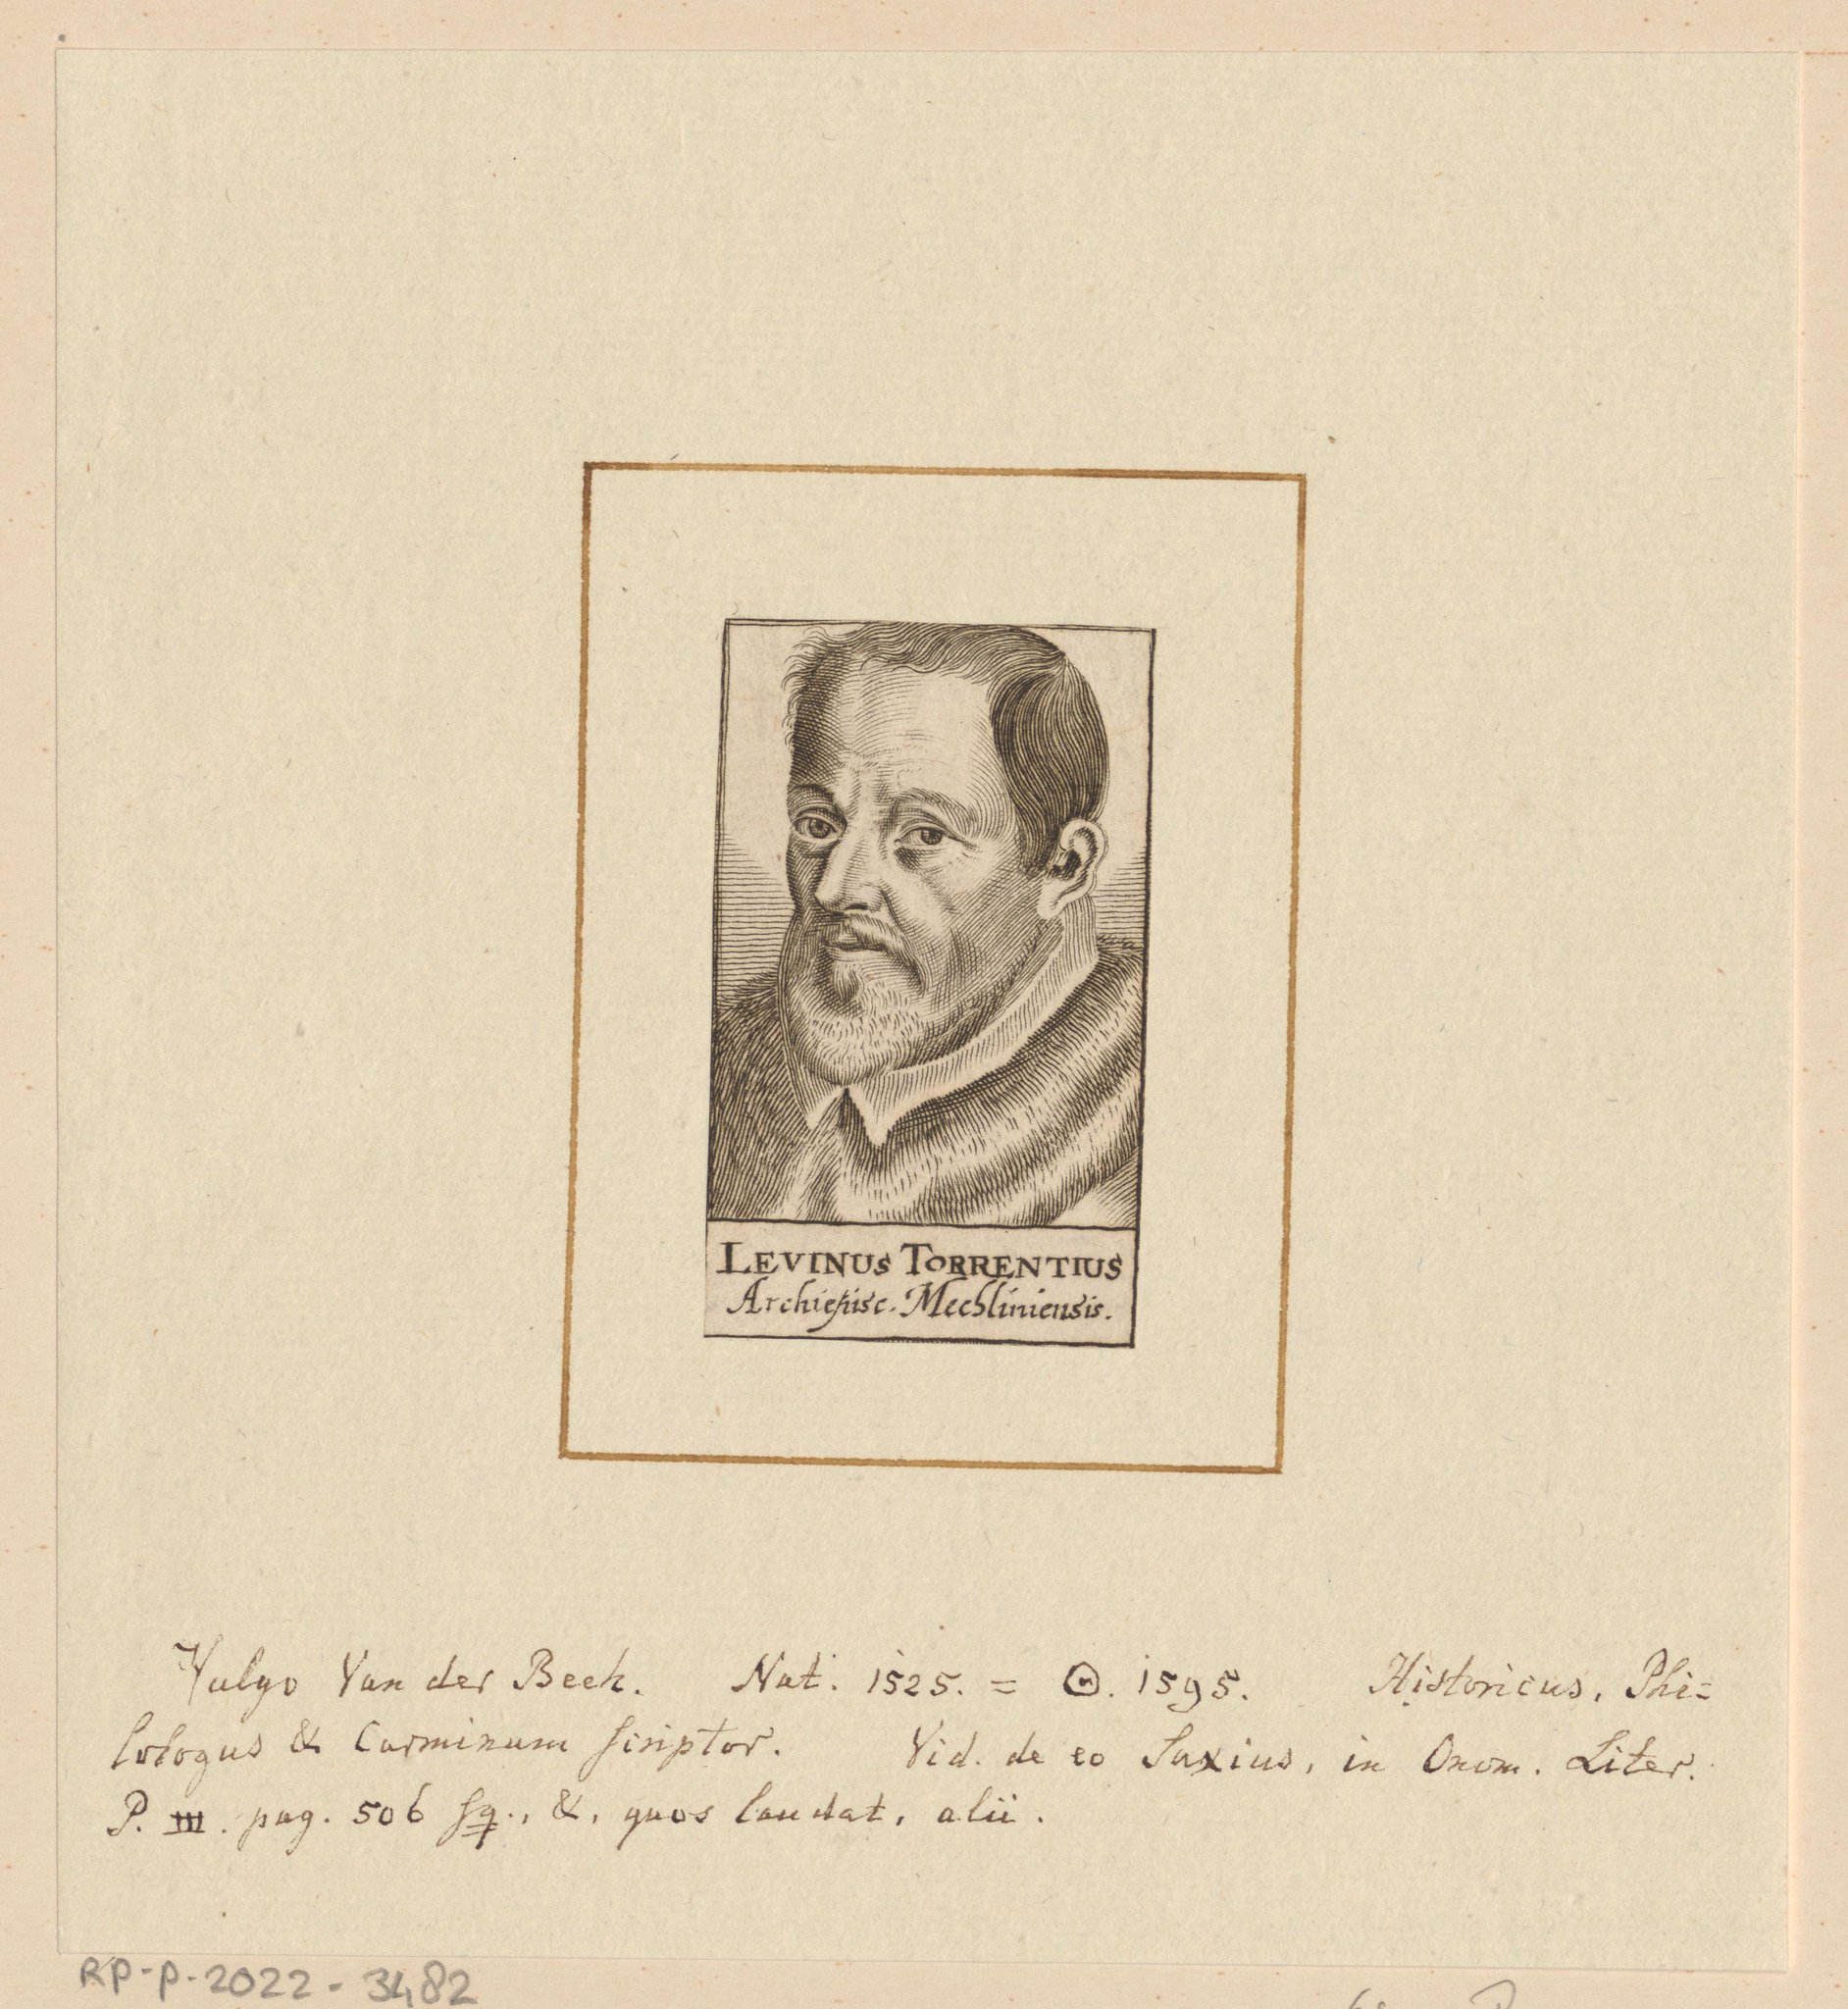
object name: print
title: Portret van Laevinus Torrentius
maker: Anonymous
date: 1688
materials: paper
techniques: engraving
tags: ghent, brussels, laevinus torrentius, archbishop, bishop, etc. (roman catholic), historical persons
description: Prent waarschijnlijk uit: Freher, Paul. Theatrum Virorum Eruditione Clarorum Tomus Posterior. Neurenberg: Johann Hofmann, 1688.